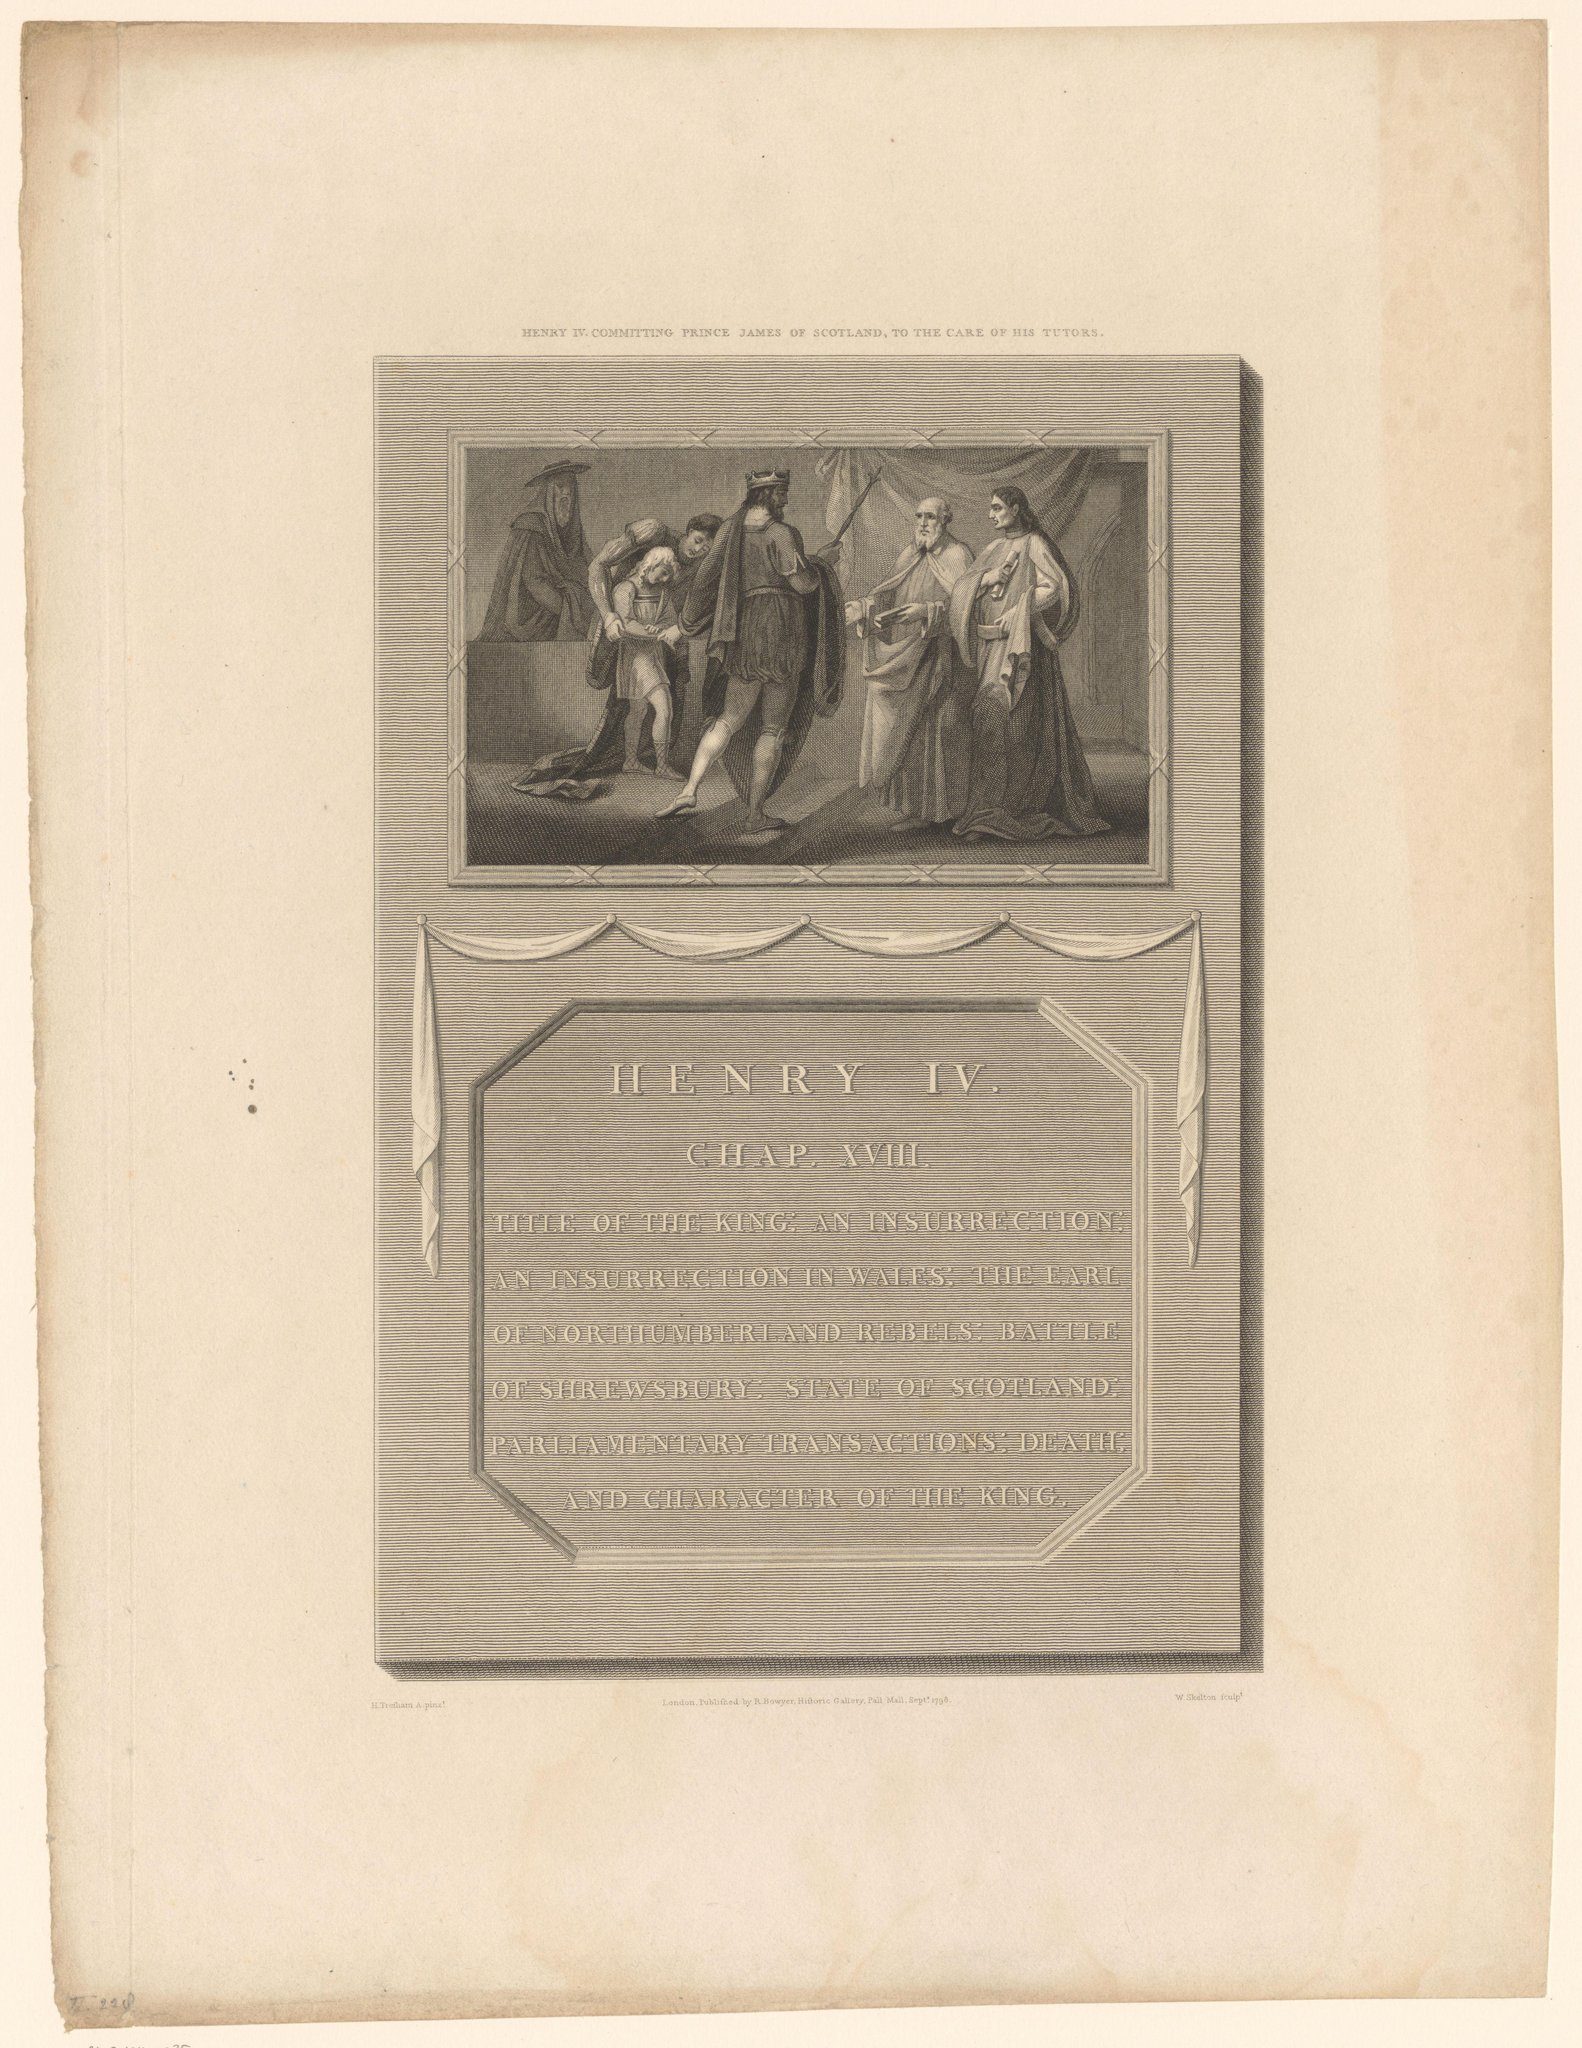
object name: print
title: Schilderijen en tekeningen bij Hume's History of England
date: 1798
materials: paper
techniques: engraving, etching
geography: london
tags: historical persons, king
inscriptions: collector's mark: Lugt 2228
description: De prenten uit deze serie zijn naar schilderijen uit Bowyer's Historic Gallery. Deze schilderijen en tekeningen illustreerden de gebeurtenissen uit David Hume's History of England. De prenten zijn daarom mogelijk gebruikt als illustratie in deze boeken.